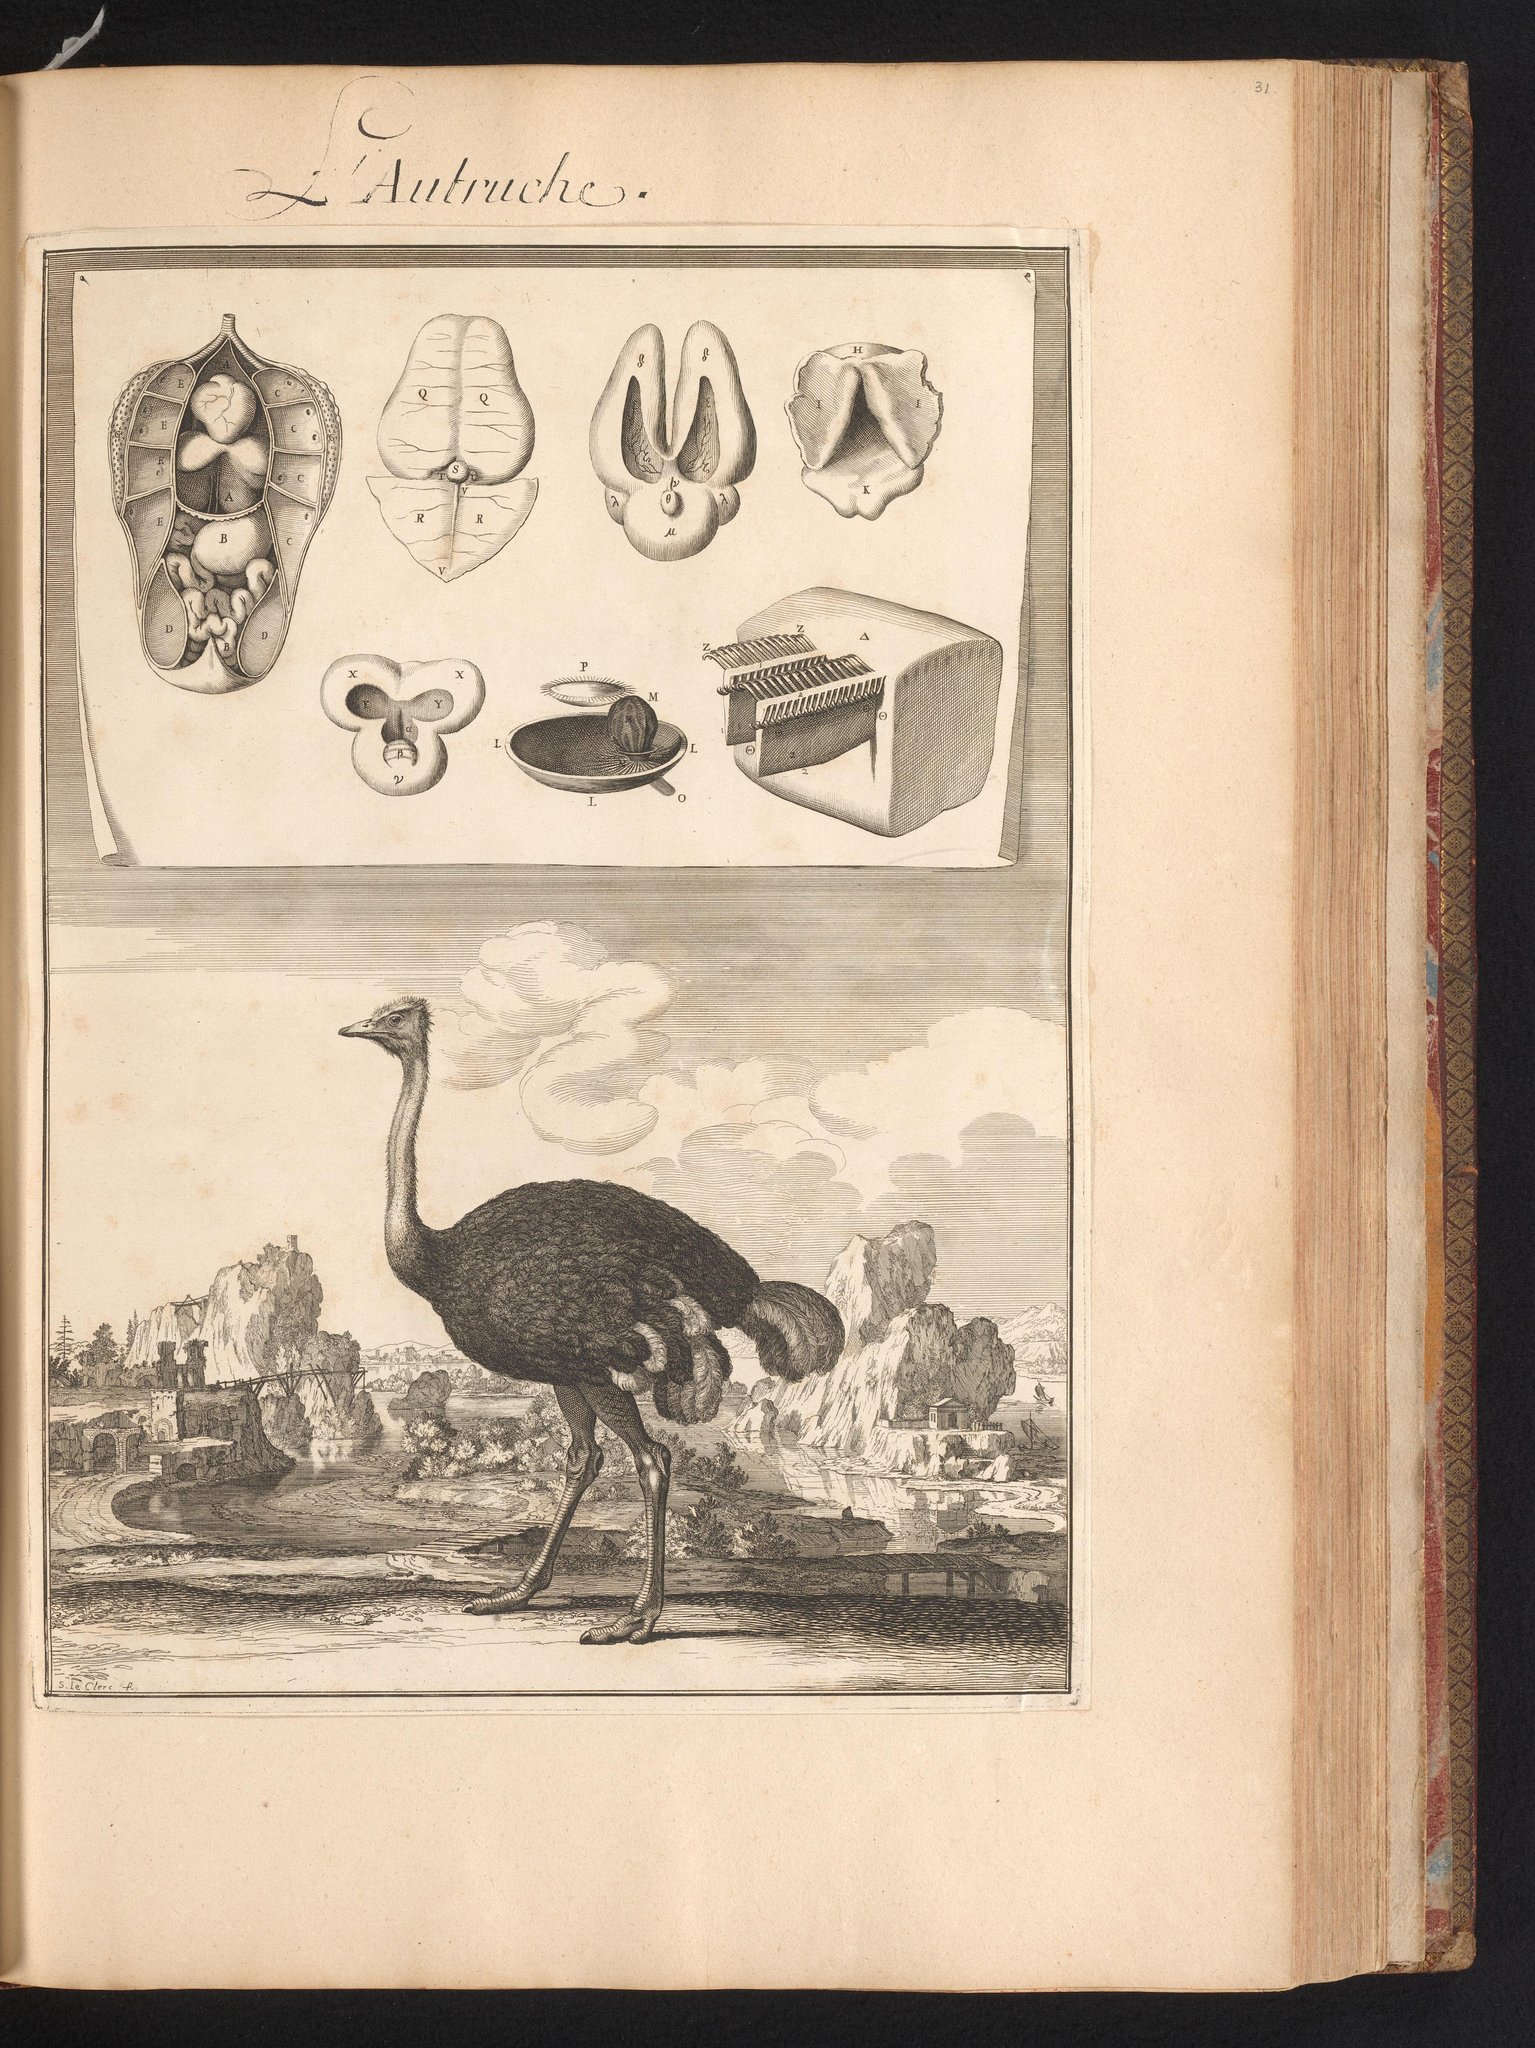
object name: album leaf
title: Struisvogel in een landschap met bovenaan op een blad de organen van het dier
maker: sébastien leclerc (i)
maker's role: print maker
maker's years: 1637-1714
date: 1676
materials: ink, paper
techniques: engraving, etching, pen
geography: paris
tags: dissection, walker and runner birds: ostrich, animals (+ anatomy of animals)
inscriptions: inscription: ‘L'Autruche.’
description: Prent uit: Perrault, Claude. Mémoires pour servir à l'histoire naturelle des animaux. Dressez par M. Perrault de l'Académie Royale des Sciences (...). Parijs: Imprimerie Royale, 1676.